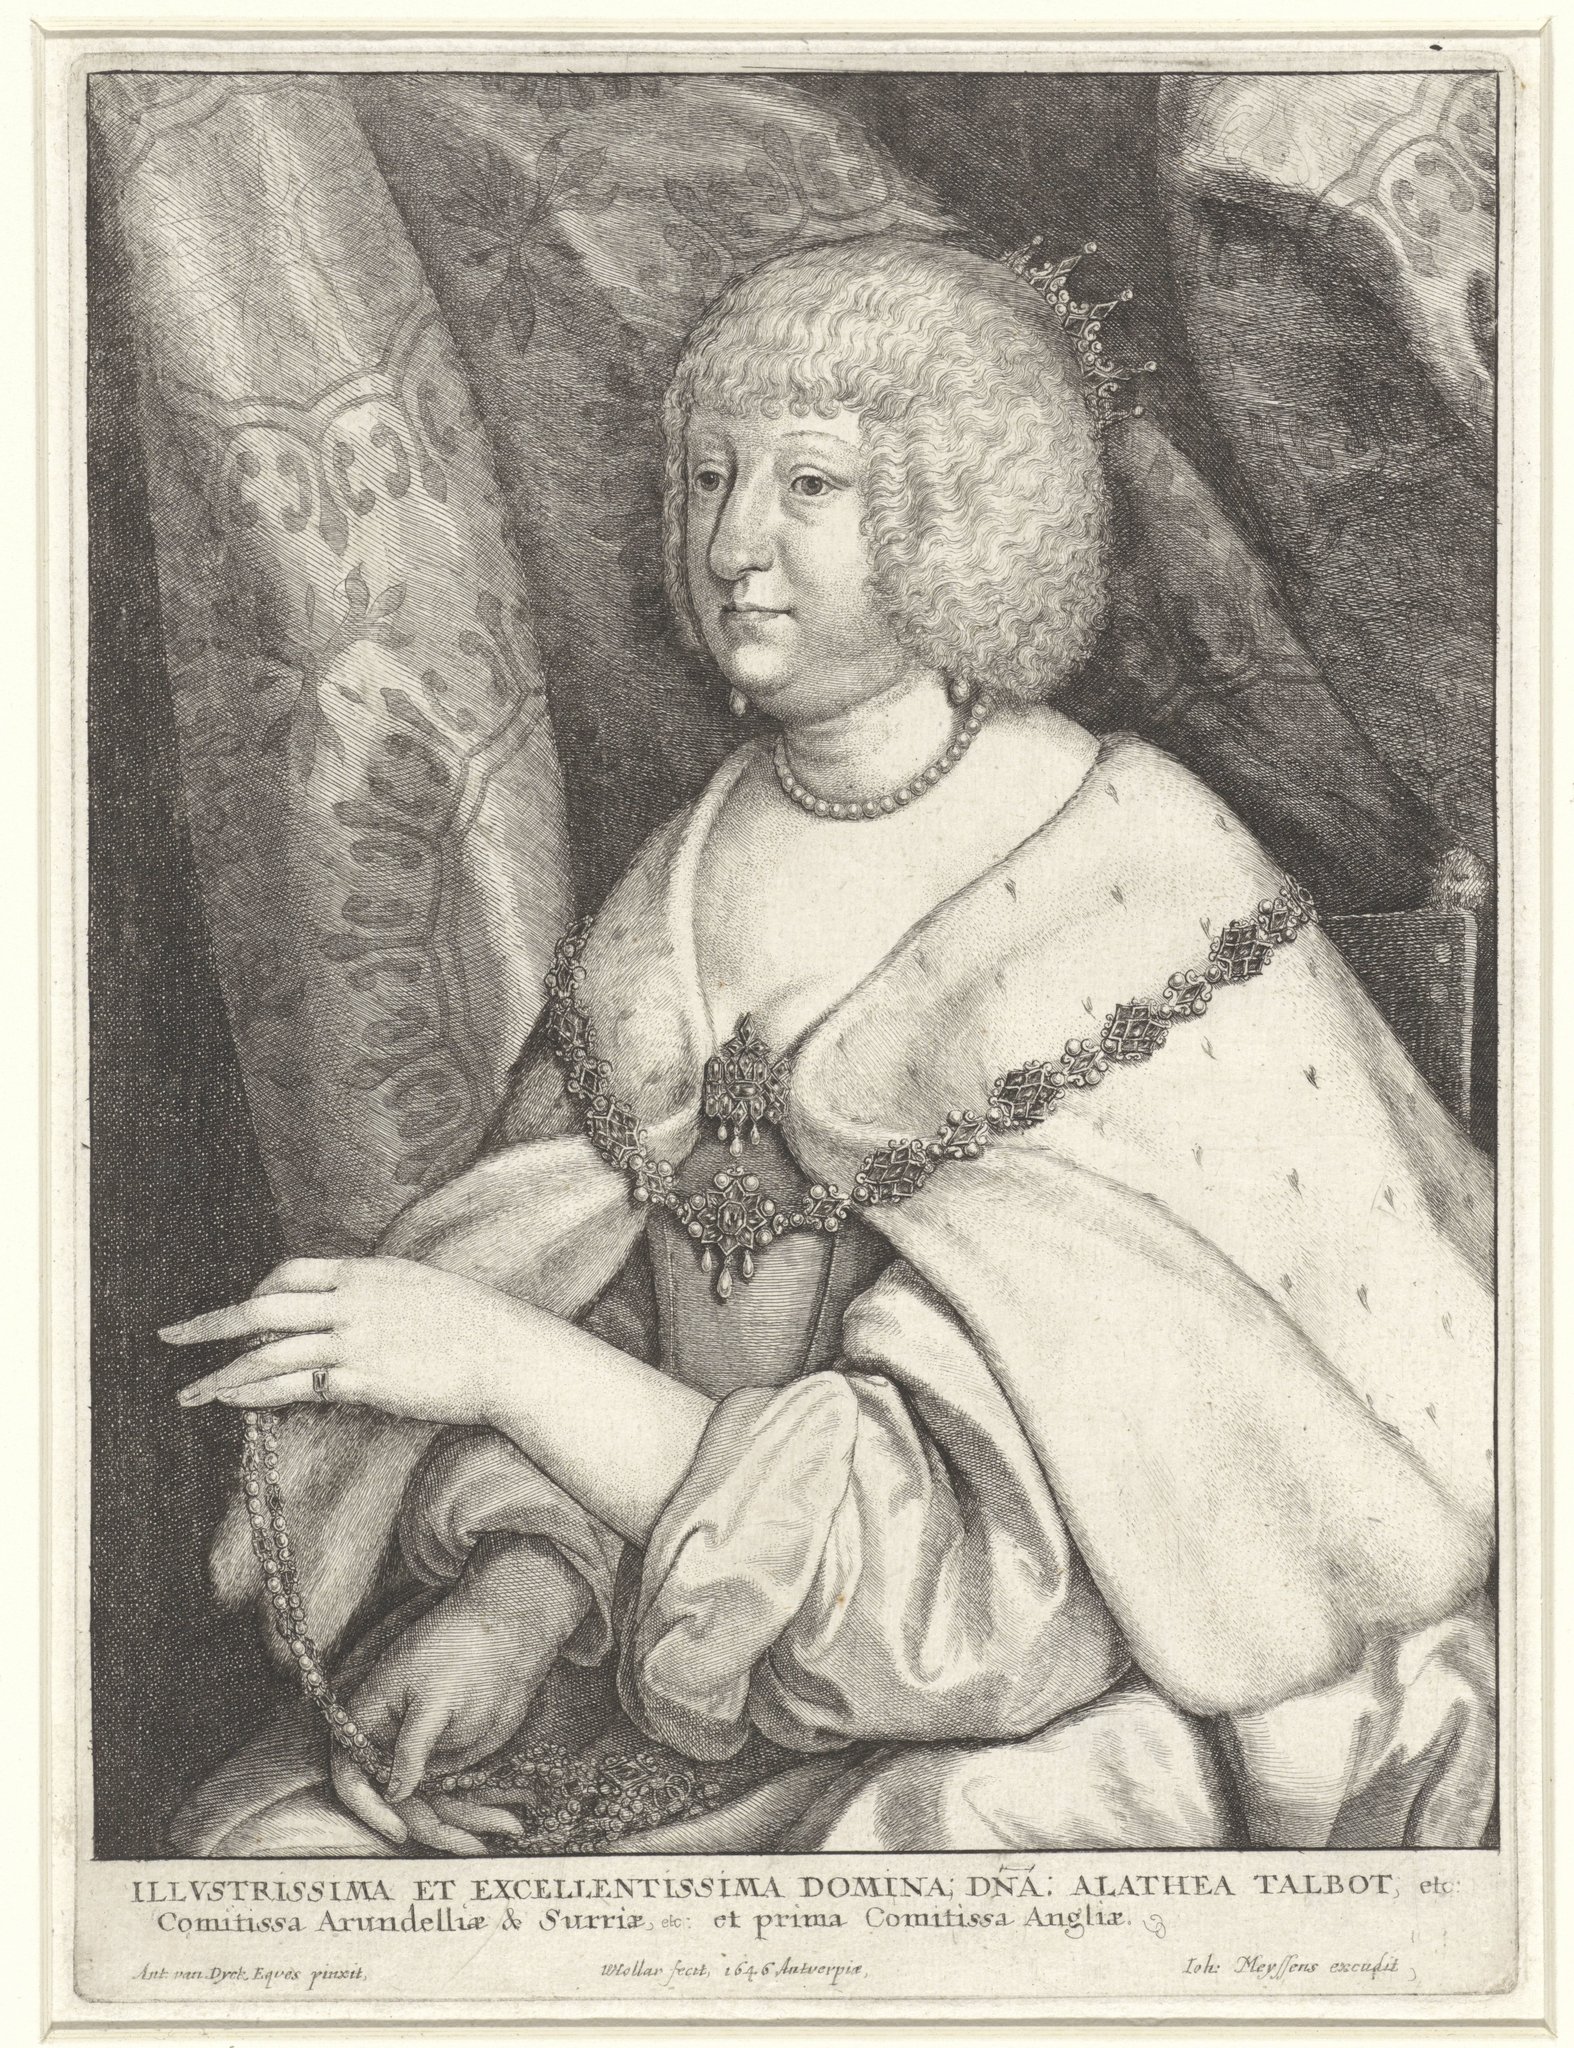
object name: print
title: Portret van Aletheia Talbot, gravin van Arundel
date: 1646-1670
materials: paper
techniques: etching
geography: antwerp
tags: alatheia talbot (gravin van arundel)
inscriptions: collector's mark: Lugt 240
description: De prent maakt deel uit van een zevendelige serie portretten naar Anthony van Dyck, uitgegeven door Joannes Meyssens.